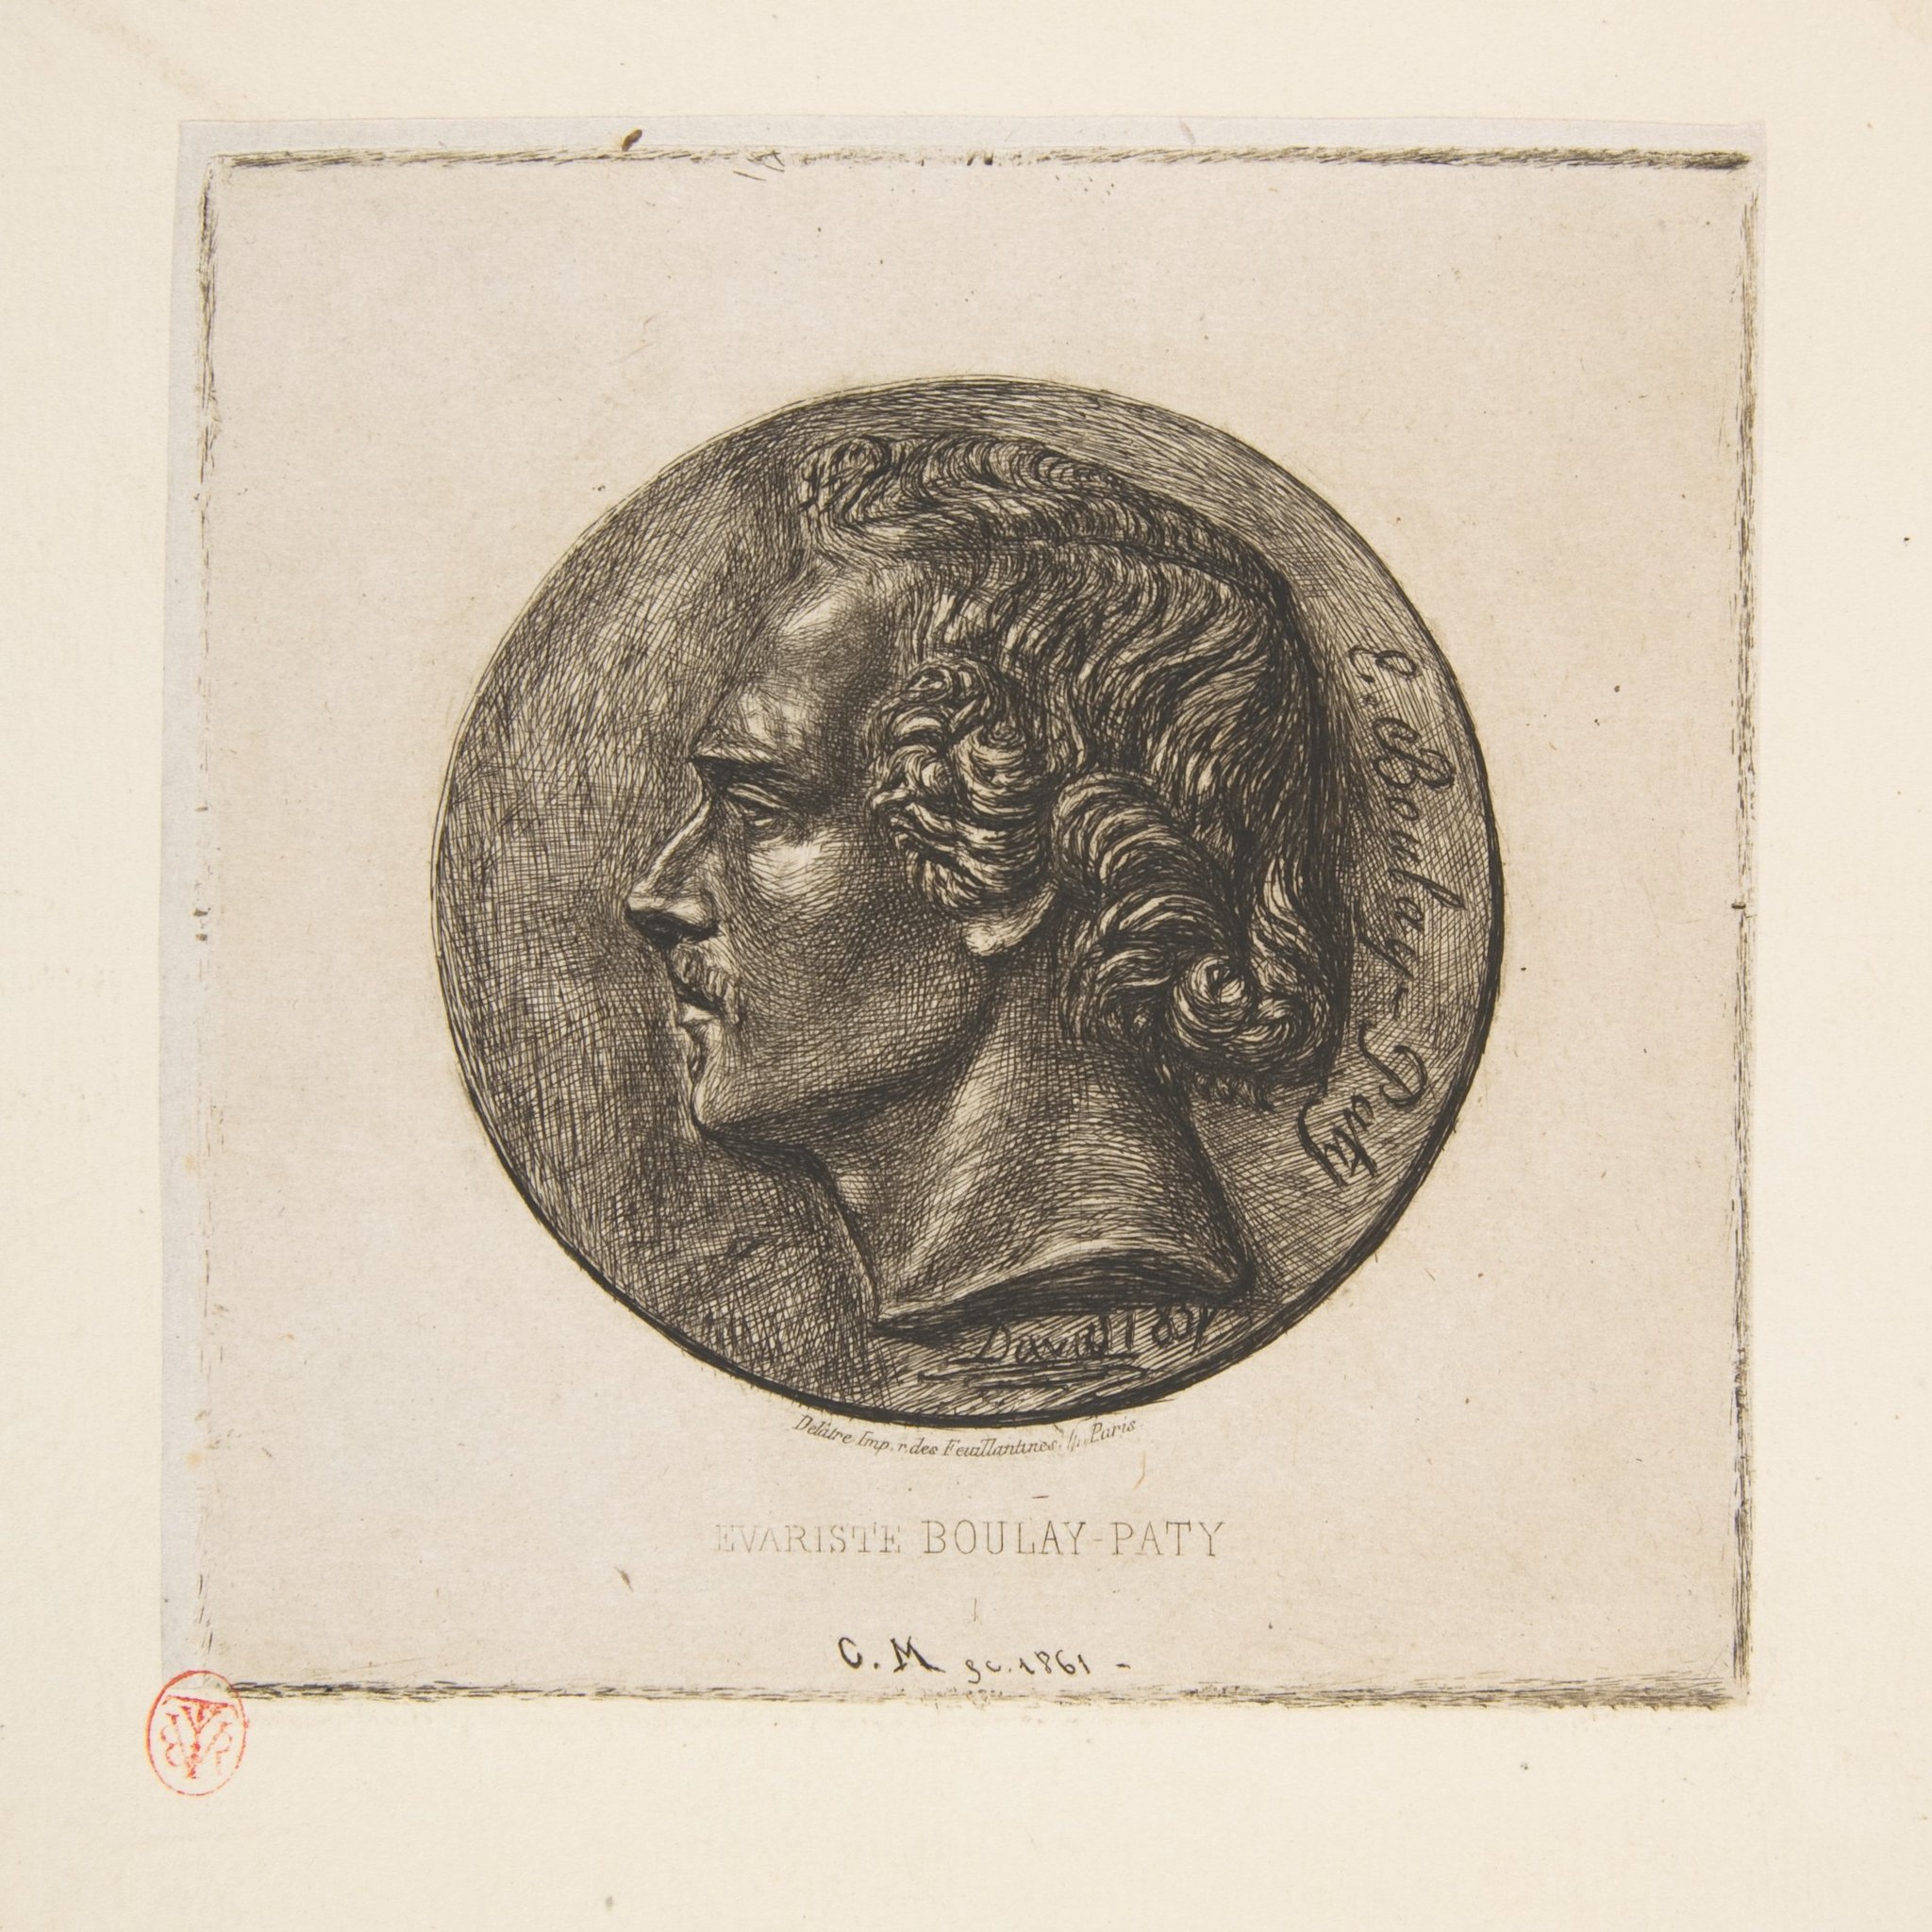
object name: print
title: Evariste Boulay-Paty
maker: charles meryon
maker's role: artist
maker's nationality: french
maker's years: 1821-1868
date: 1861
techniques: etching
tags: men,profiles